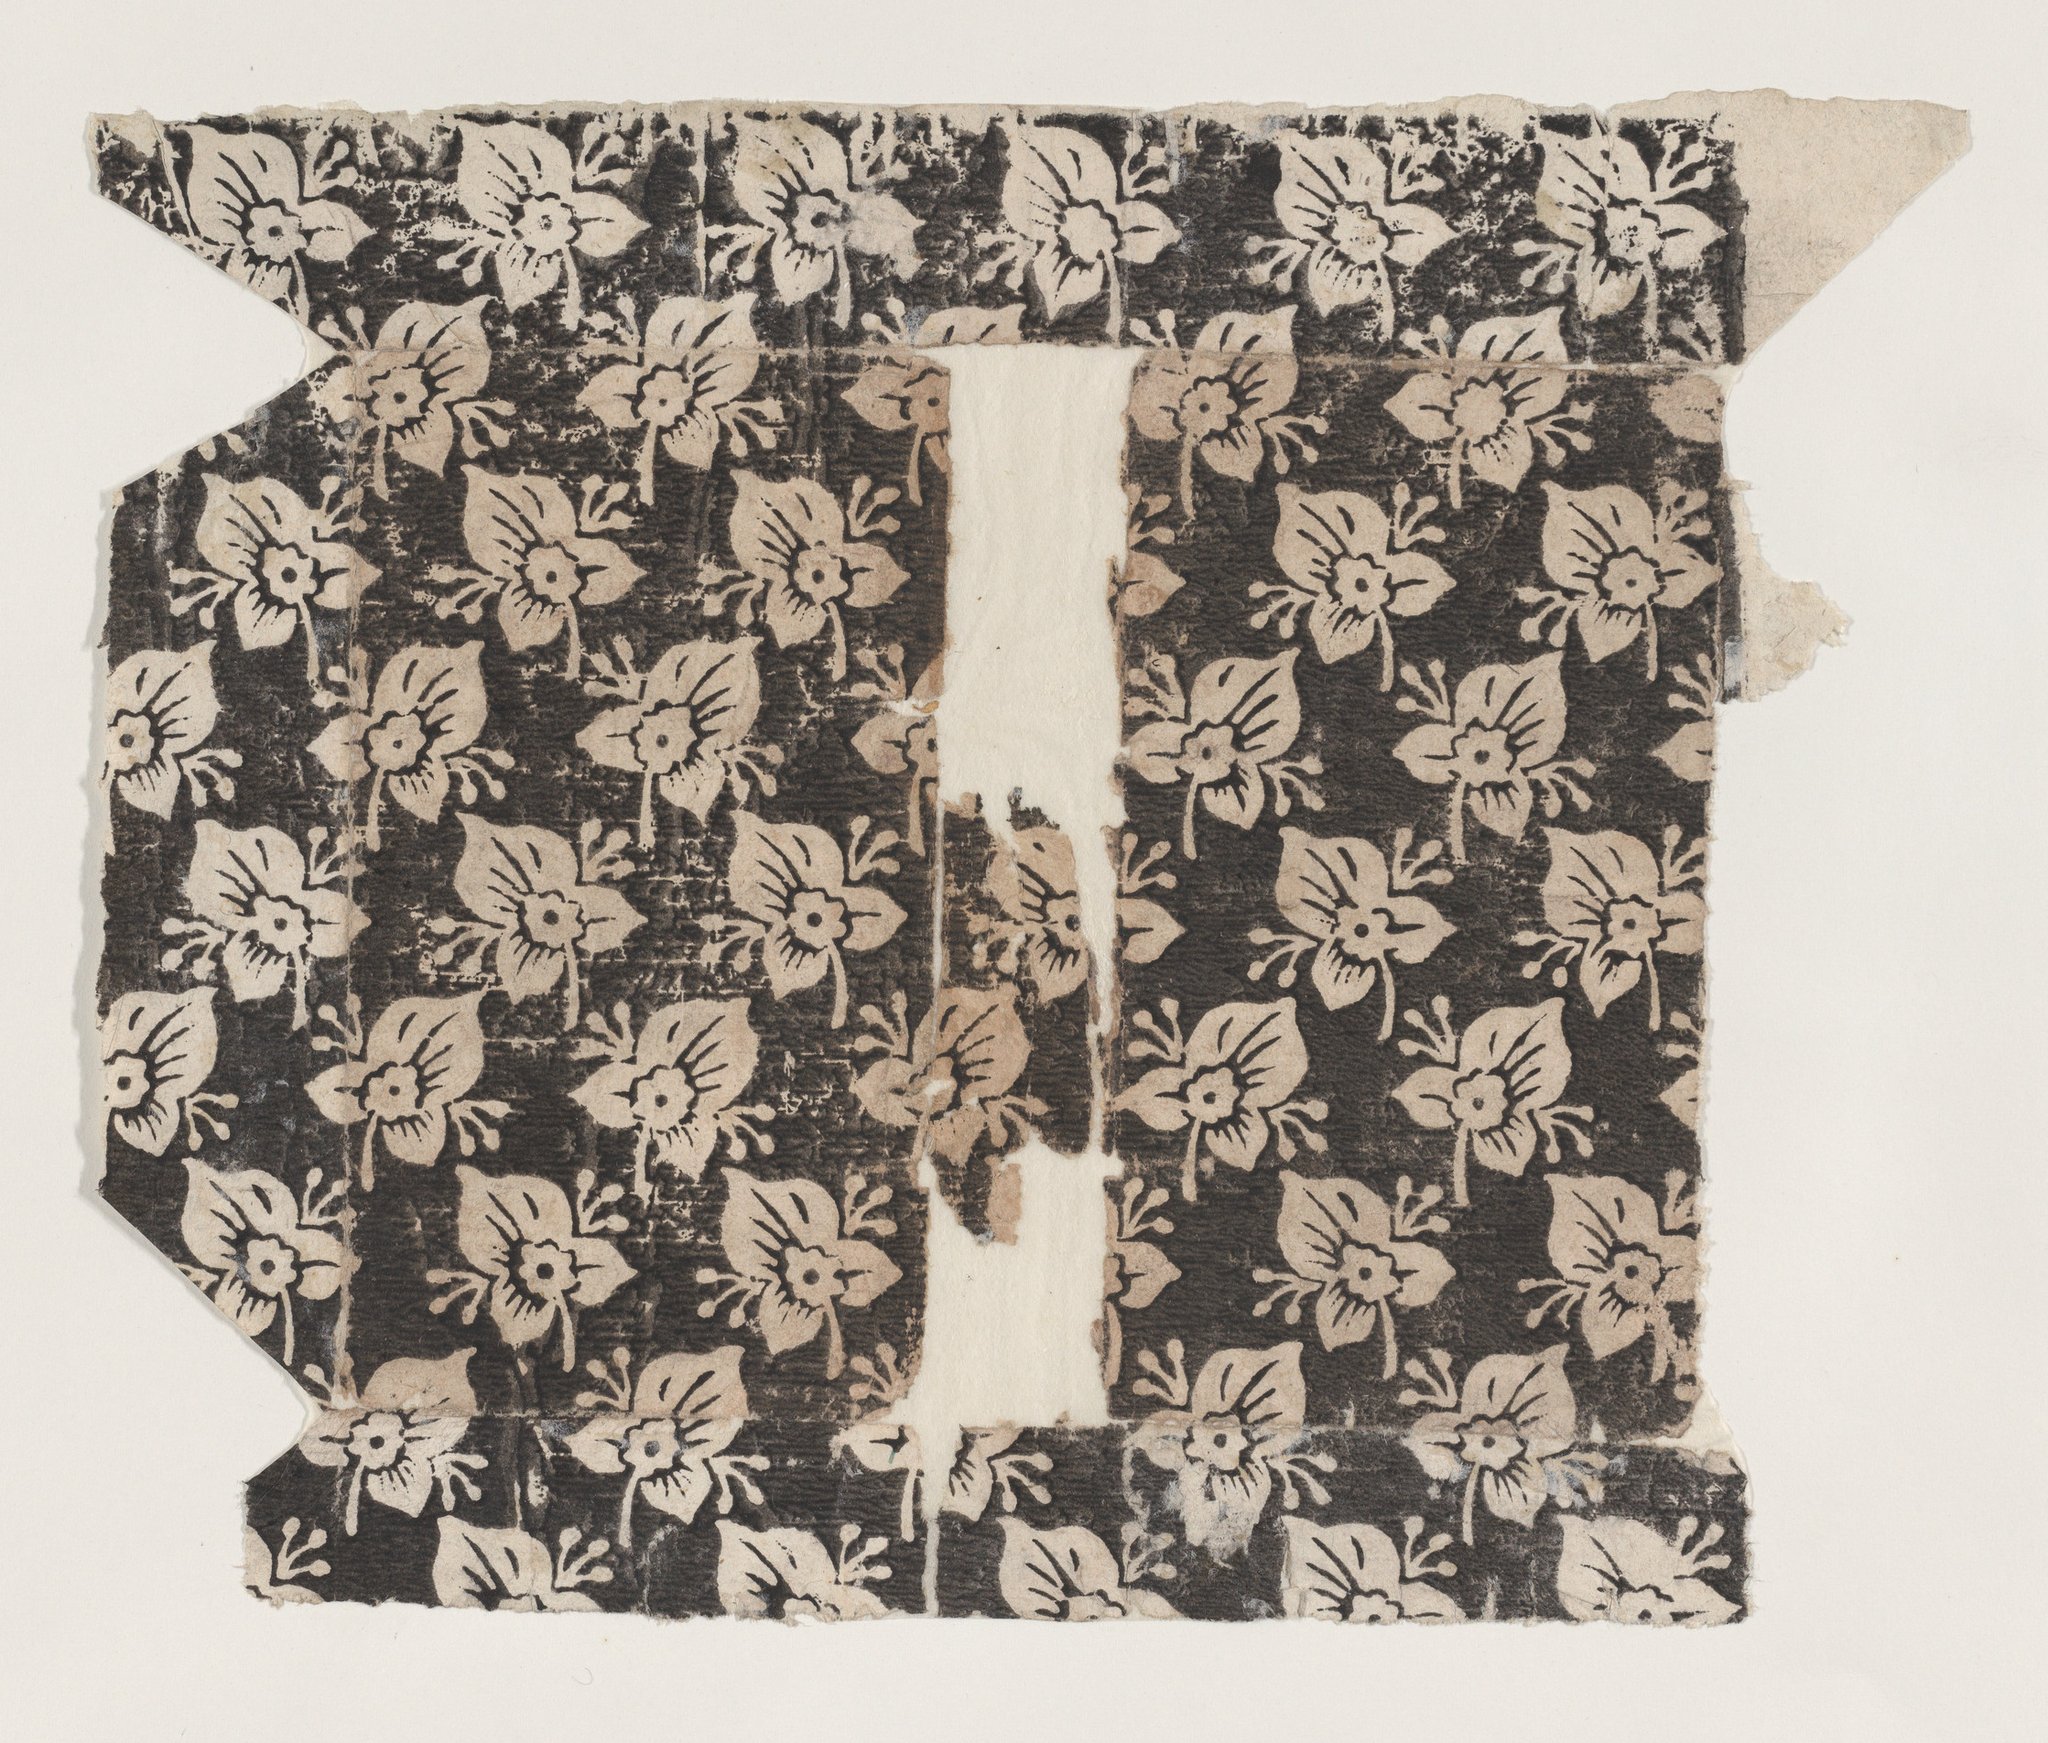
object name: print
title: Sheet with overall floral pattern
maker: Anonymous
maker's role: artist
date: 1801-1900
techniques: relief print